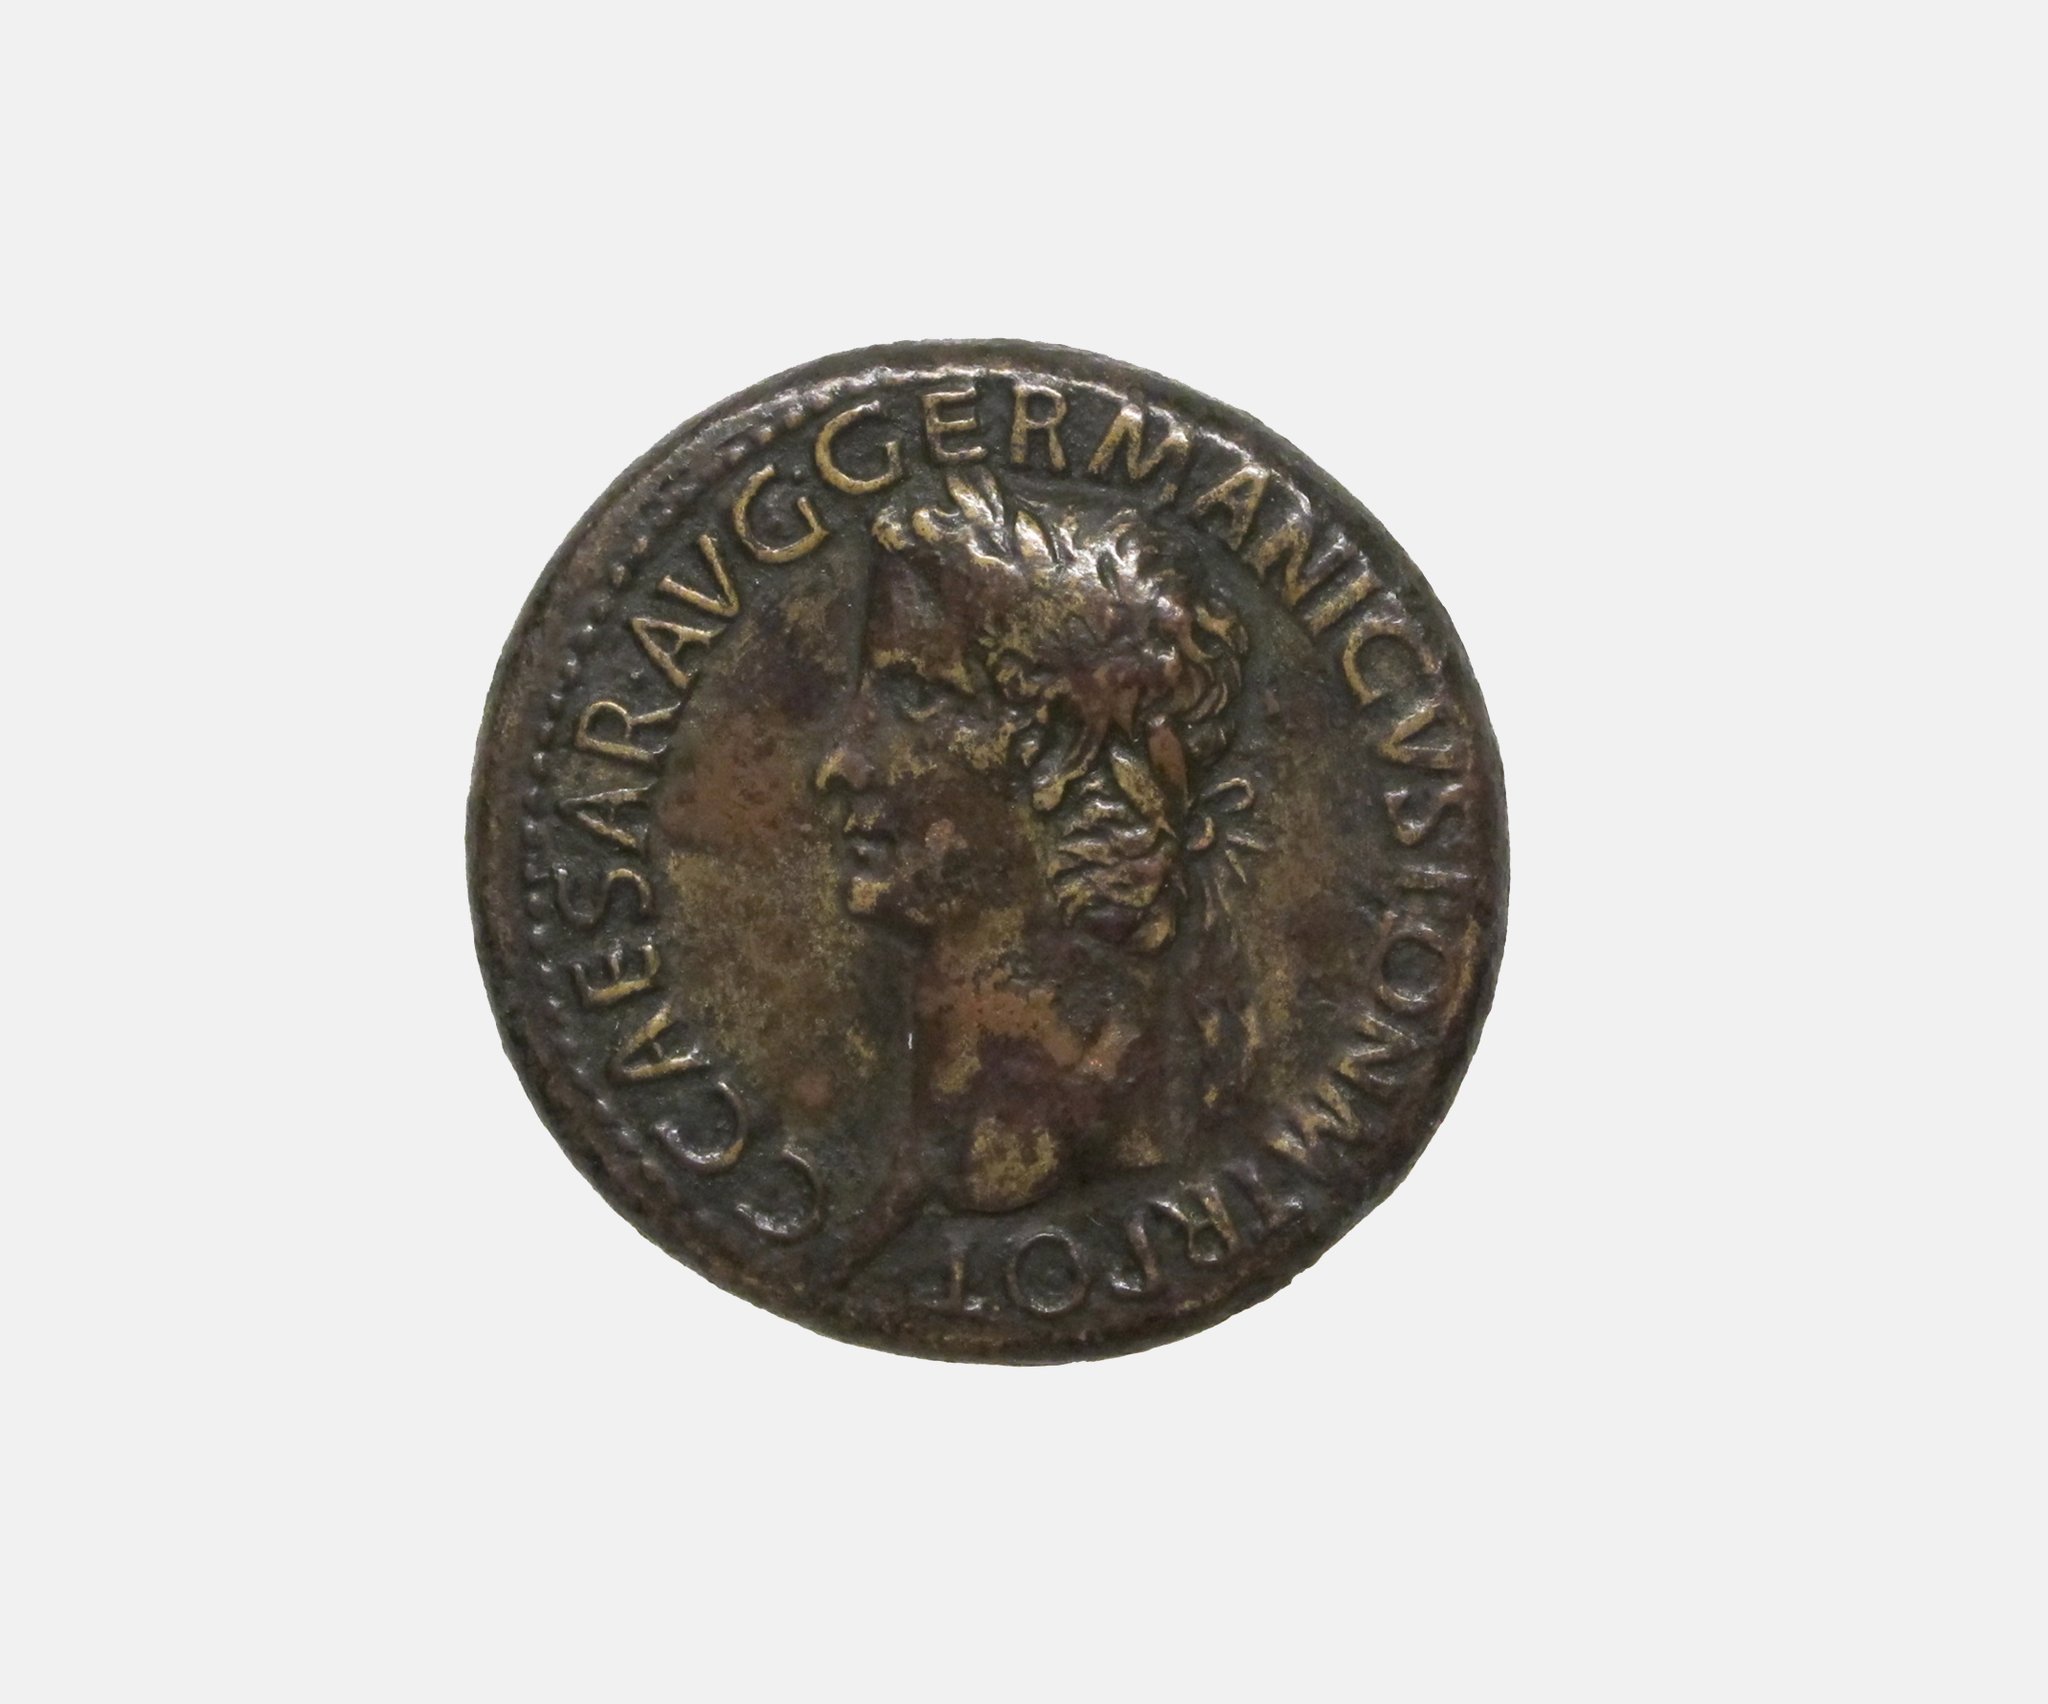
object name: sestertius of caligula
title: Bronze sestertius of Gaius (Caligula)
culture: roman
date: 37-38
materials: bronze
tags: men,profiles